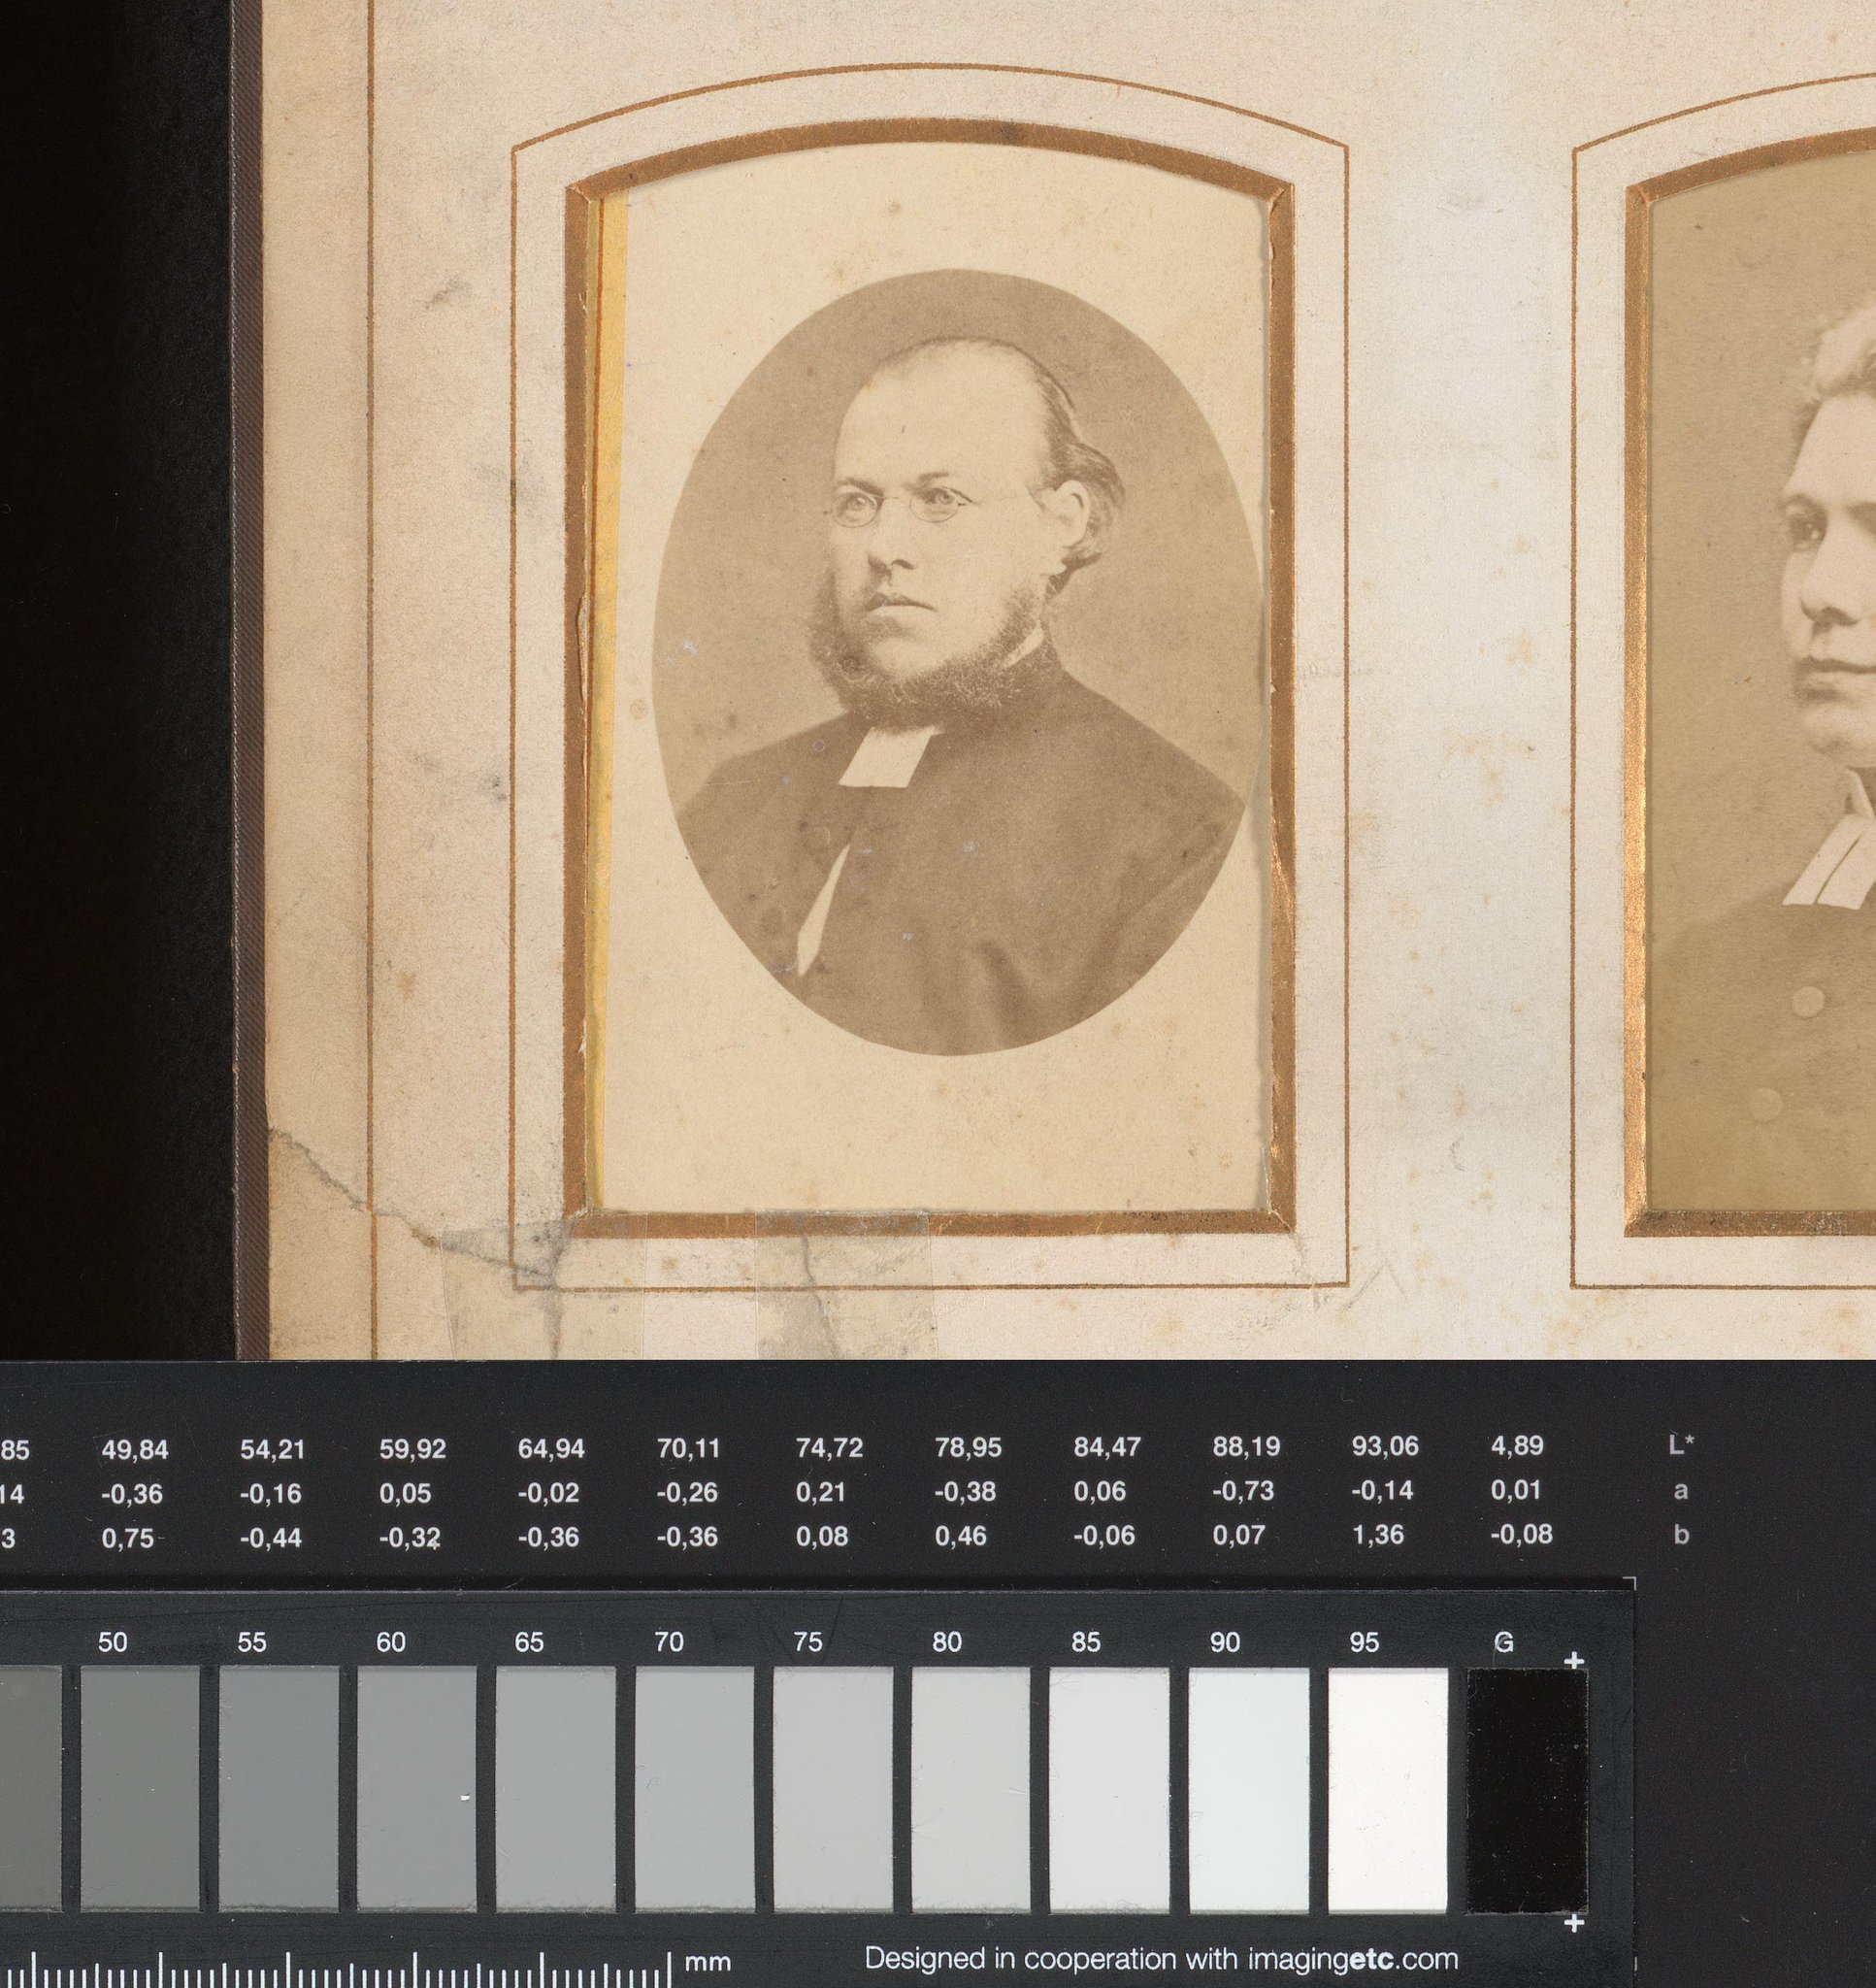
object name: photograph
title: Portret van een man met ringbaard en bril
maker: Anonymous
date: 1860-1900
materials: cardboard, photographic support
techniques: albumen print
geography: sweden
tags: eyeglasses, spectacles, historical persons, beard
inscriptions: annotation: ‘Zweeds’